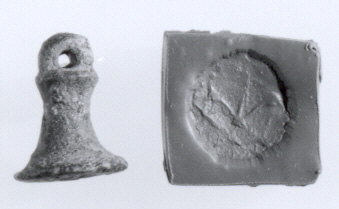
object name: stamp seal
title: Stamp seal (bell-shaped with loop handle) with monster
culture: urartian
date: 800-601 BCE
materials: alloy, bronze, copper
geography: urartu